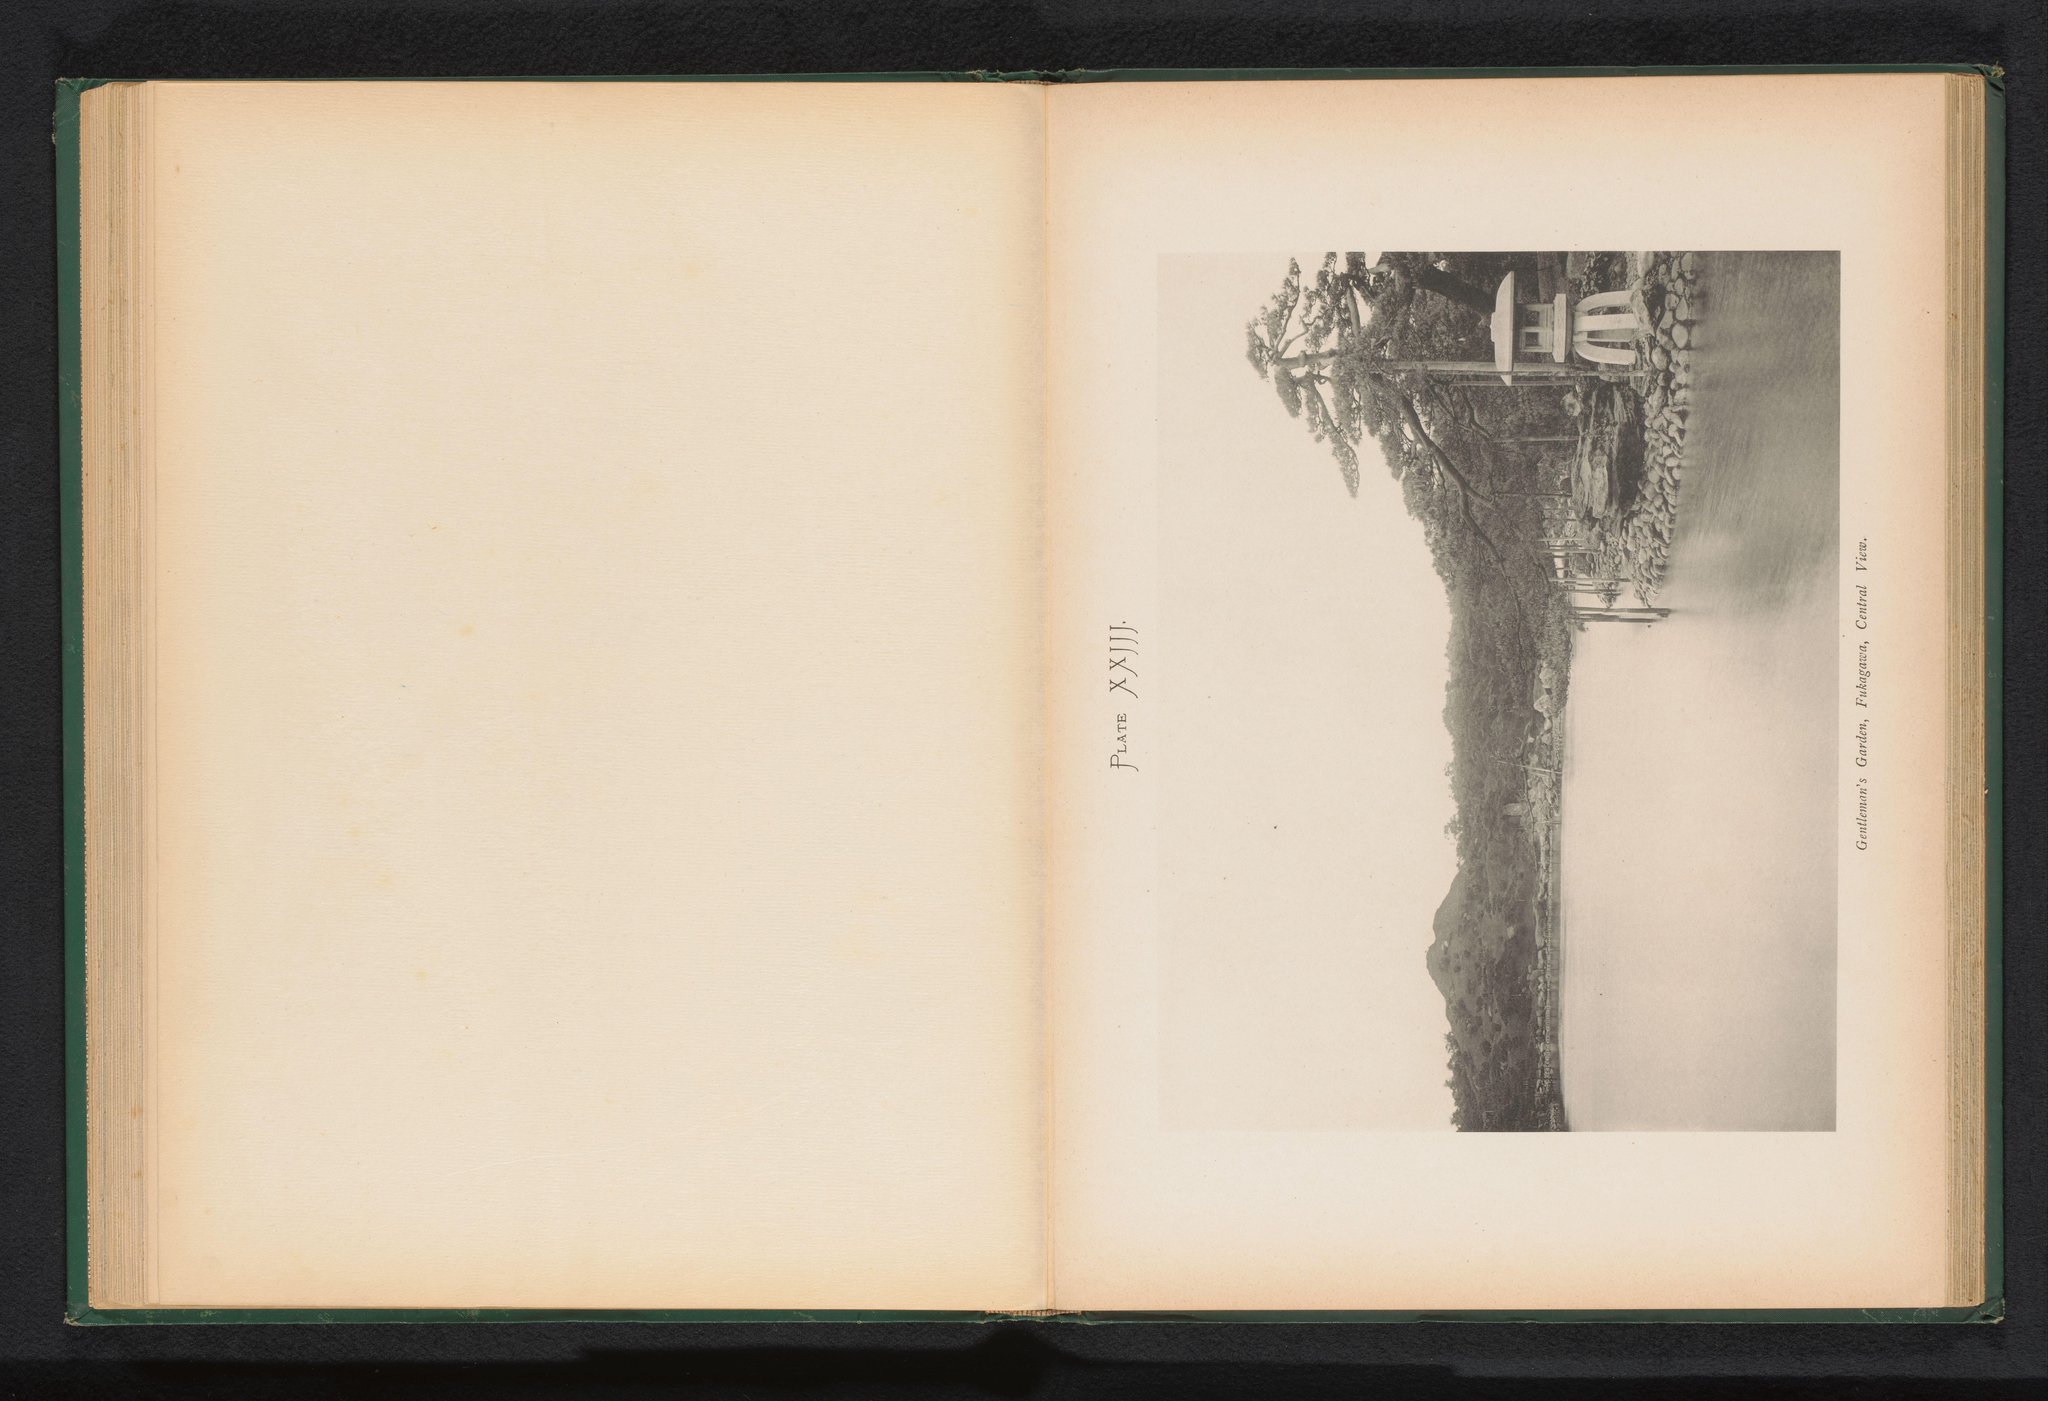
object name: page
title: Gentleman's Garden, Fukagawa, Central View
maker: kazumasa ogawa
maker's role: auteur, fotograaf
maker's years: 1860-1929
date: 1888-1893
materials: paper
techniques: photograph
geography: fukagawa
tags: garden, pond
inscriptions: inscription: ‘Plate XXIII.’